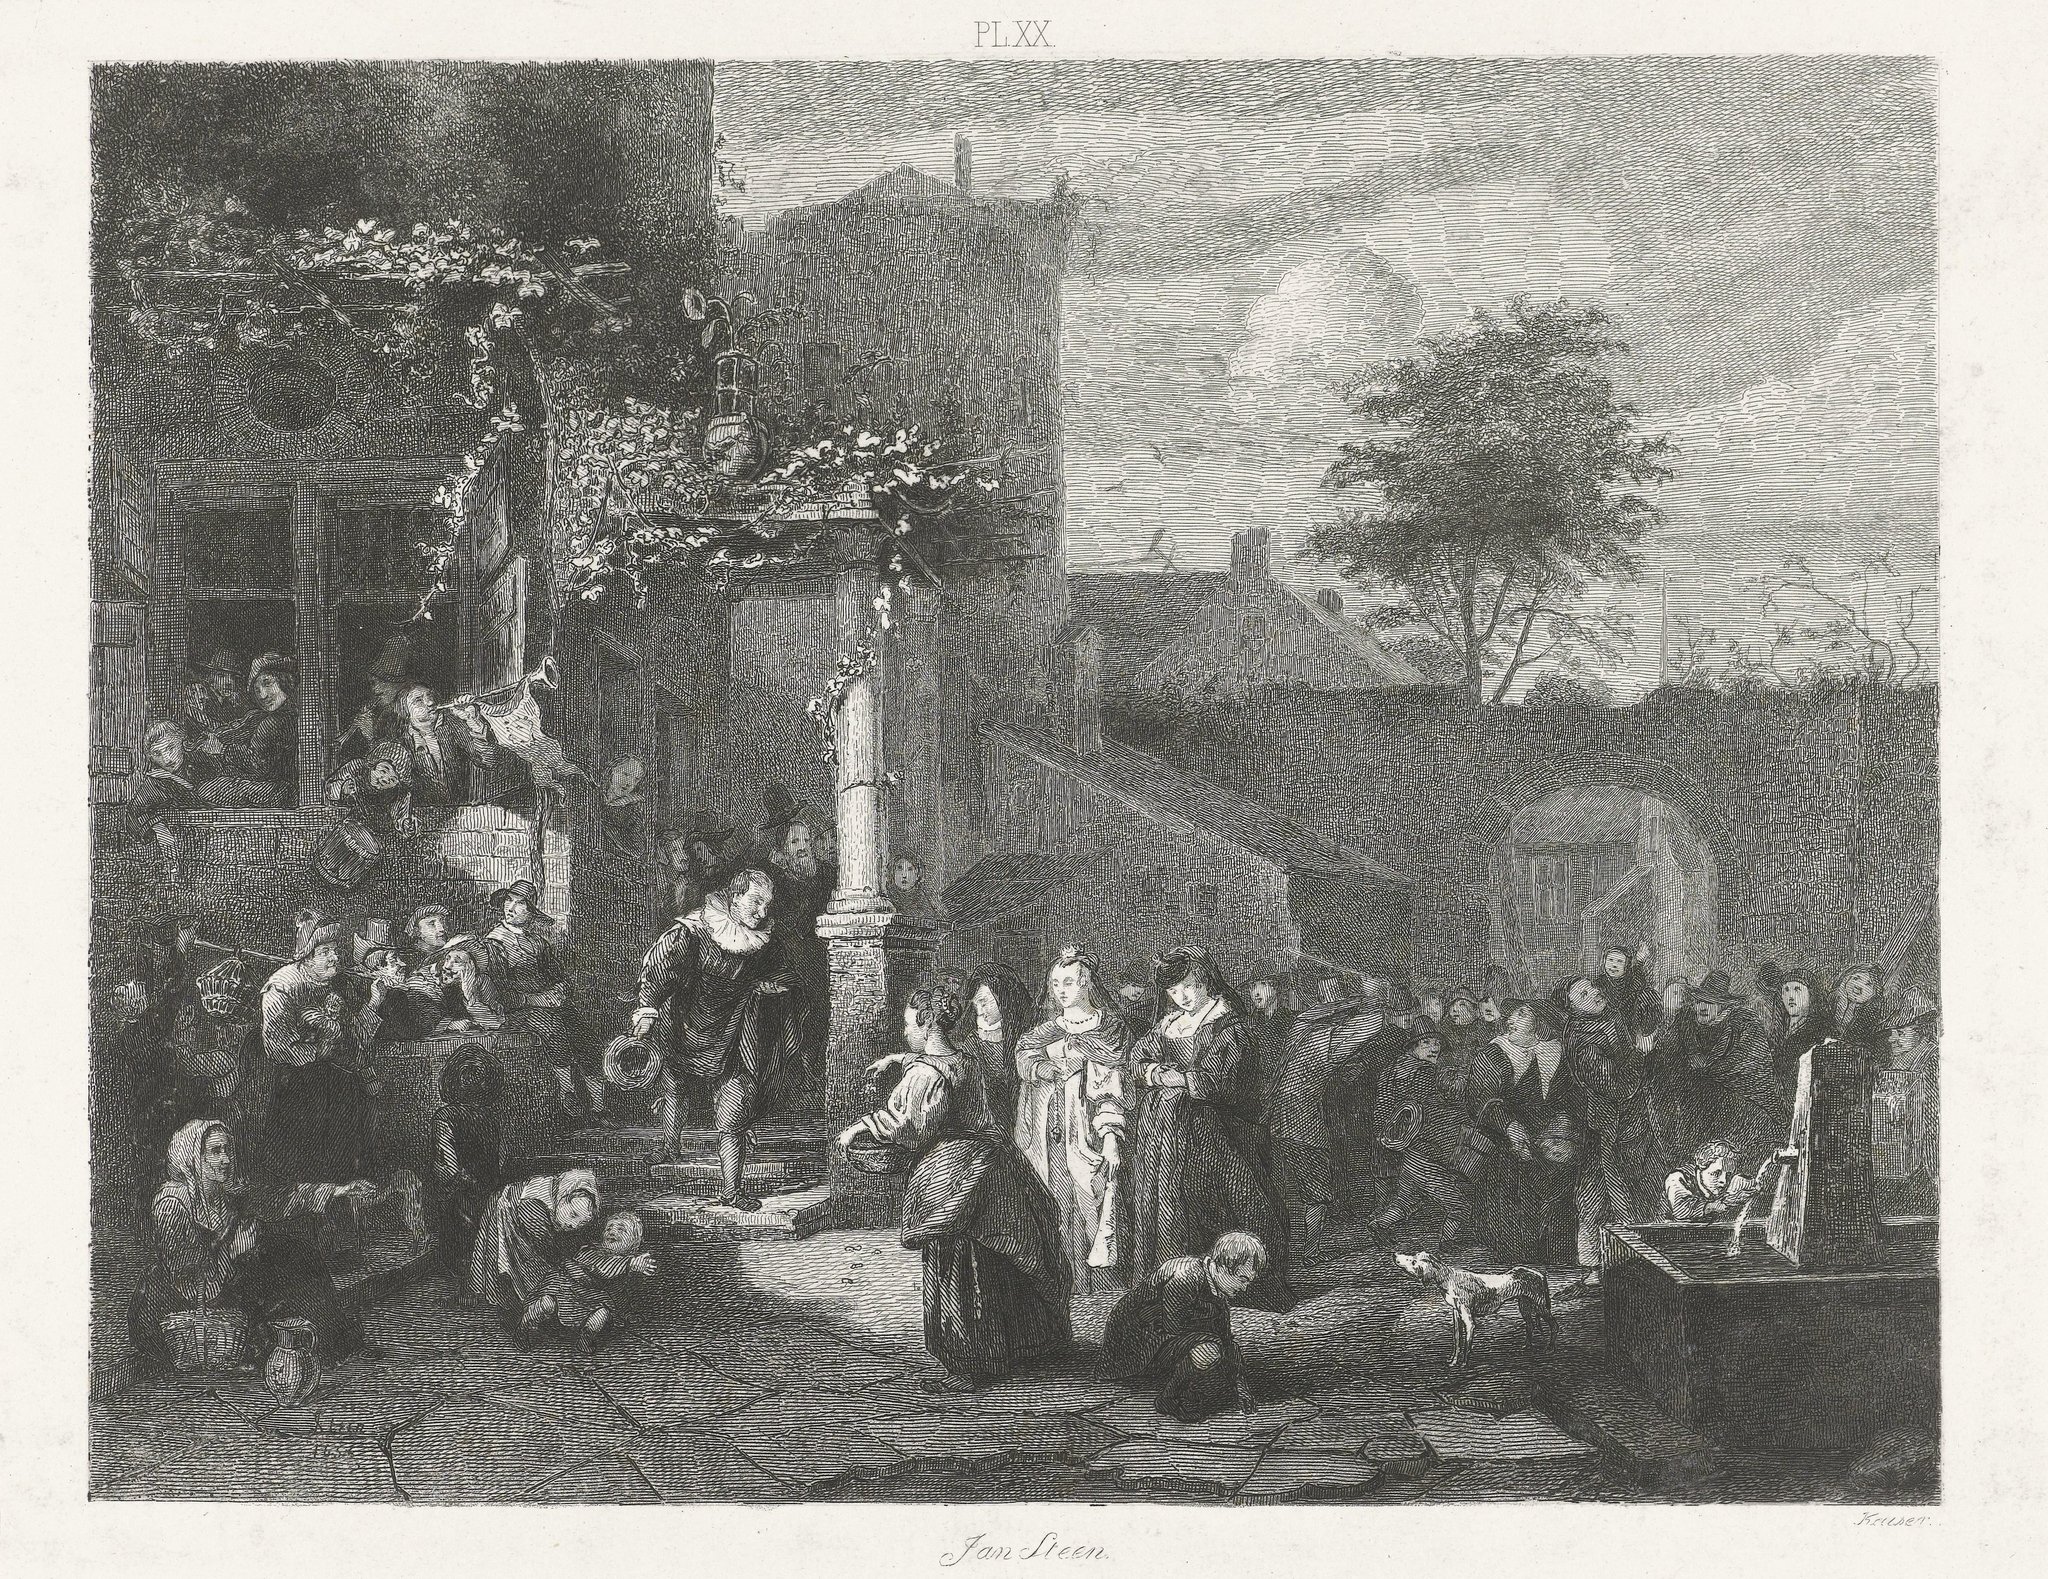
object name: print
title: Hollandse meesters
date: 1823-1900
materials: paper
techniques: etching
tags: arrival of bride and bridegroom at the wedding feast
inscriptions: collector's mark: Lugt 2228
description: Een dorpsbruiloft met vele gasten. Op de voorgrond strooit een vrouw rozen. De bruid heeft een kroon op. De bruidegom loopt de trap van een herberg af, in de richting van de bruid. De prent maakt deel uit van een serie van 25 prenten naar Hollandse meesters. Boven de afbeelding: PL XX.